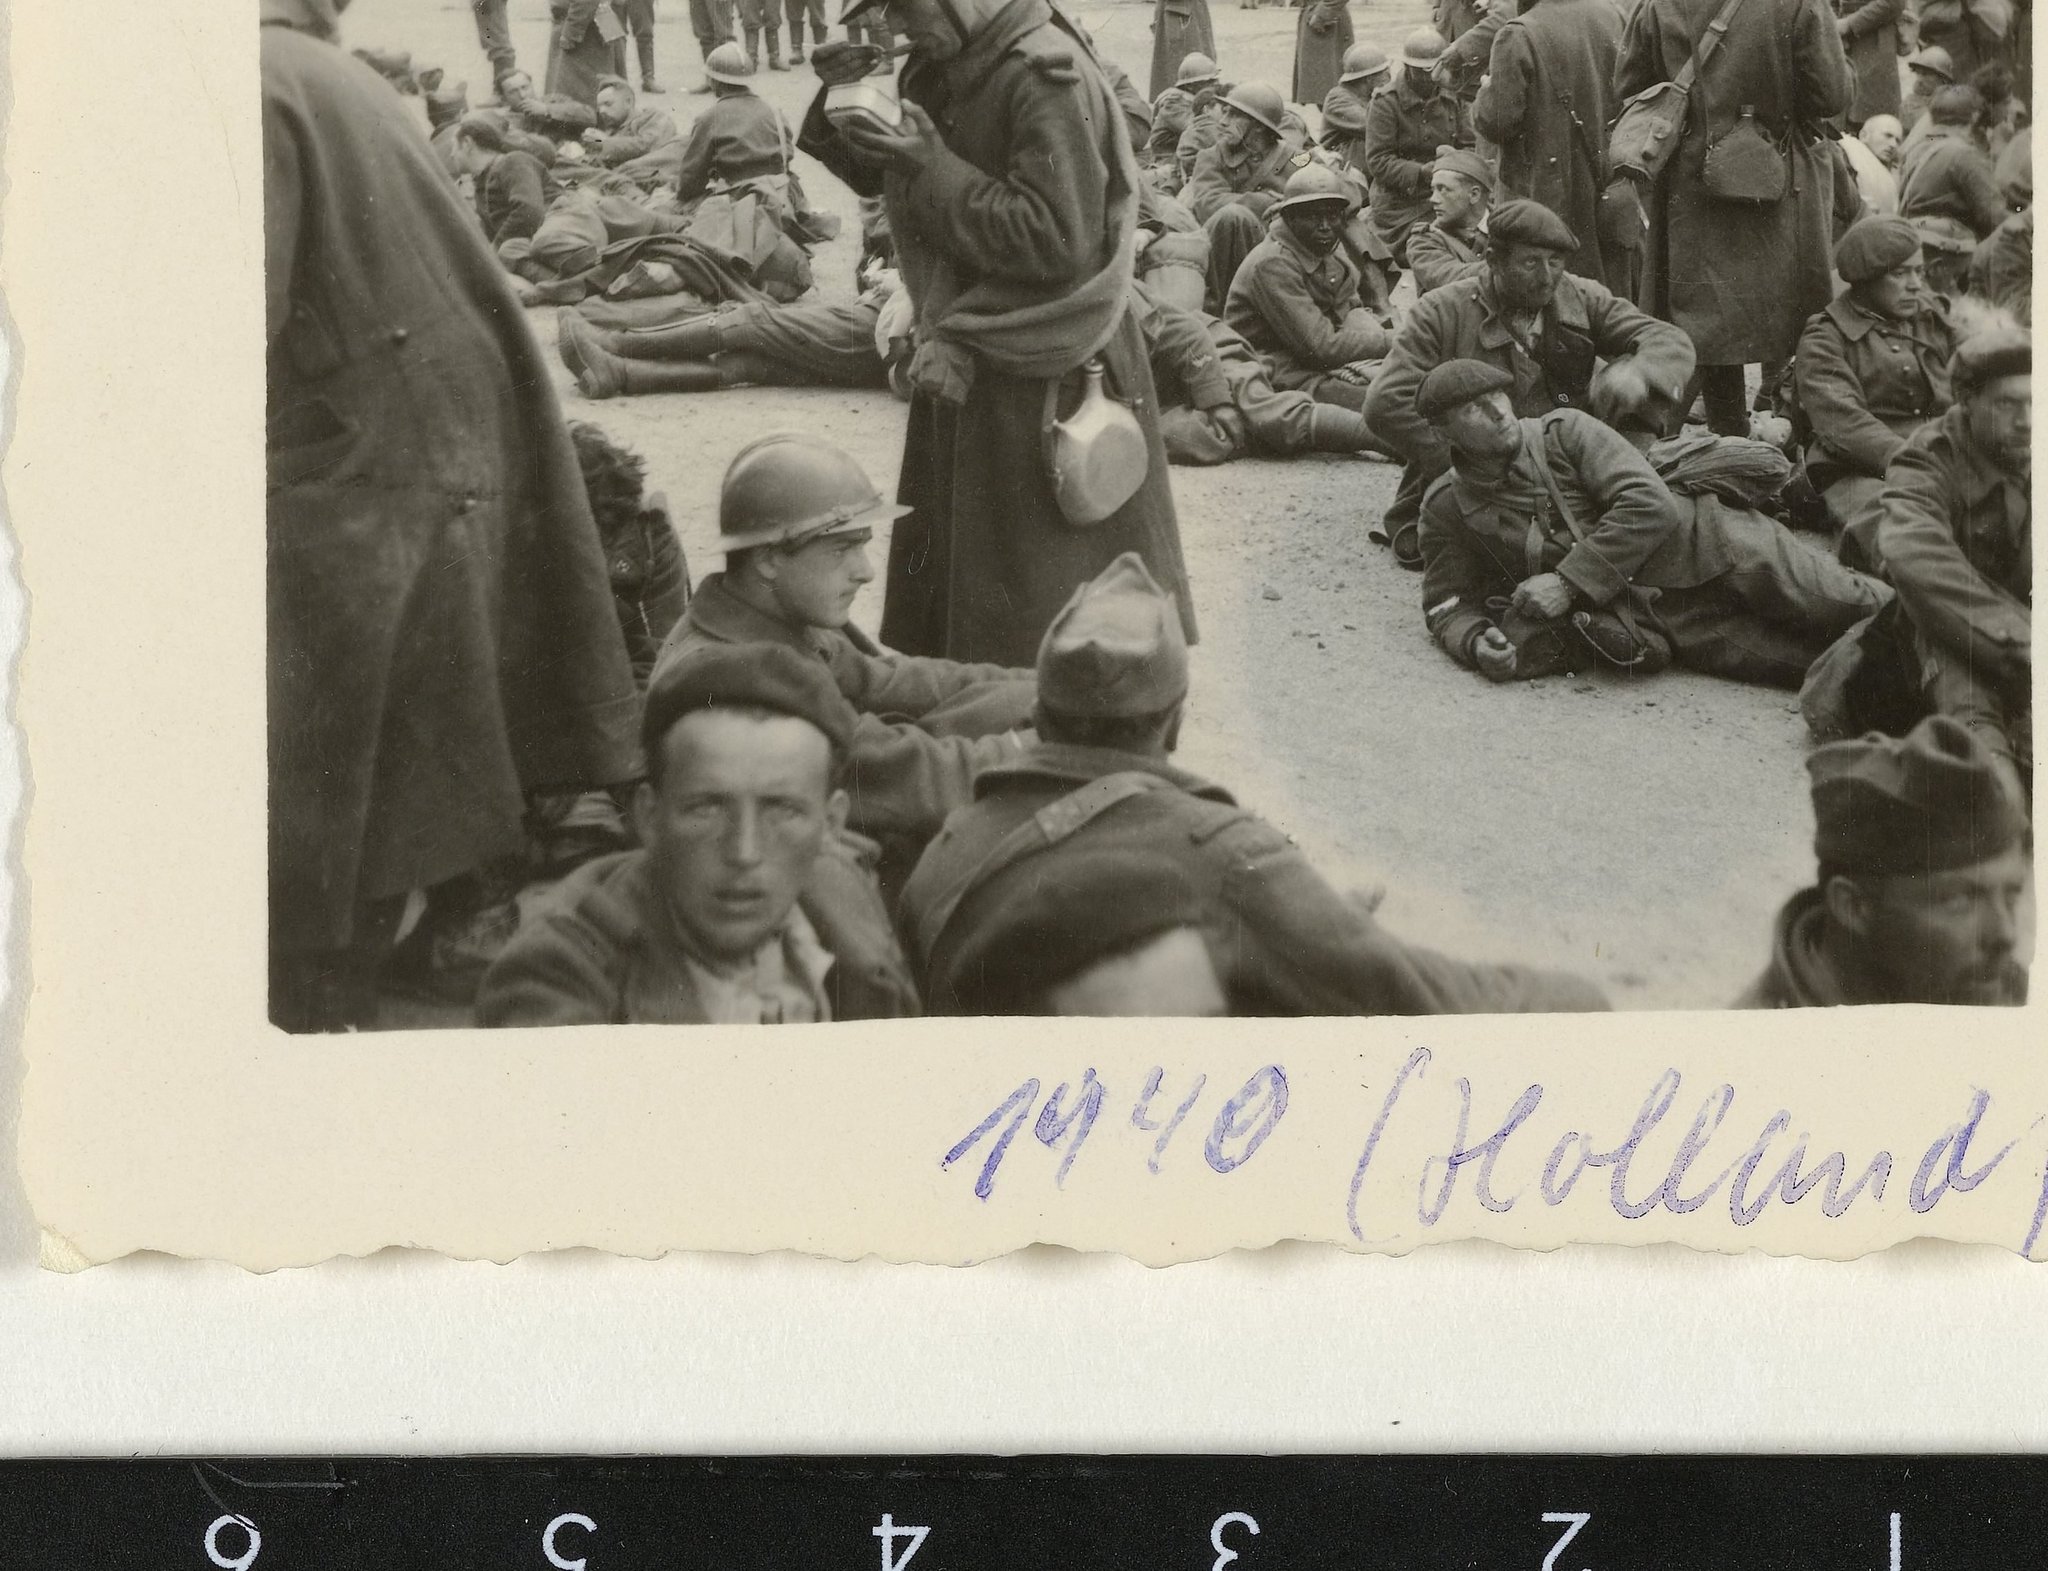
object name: photograph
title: Franse krijgsgevangenen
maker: Anonymous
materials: photographic support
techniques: gelatin silver print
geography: france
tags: occupation ~ war, prisoner of war (after the battle), france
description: Franse krijgsgevangenen, de meesten zitten op de grond. Op de achtergrond zijn een paar Duitse militairen te zien. De winkels hebben opschriften in het Frans.